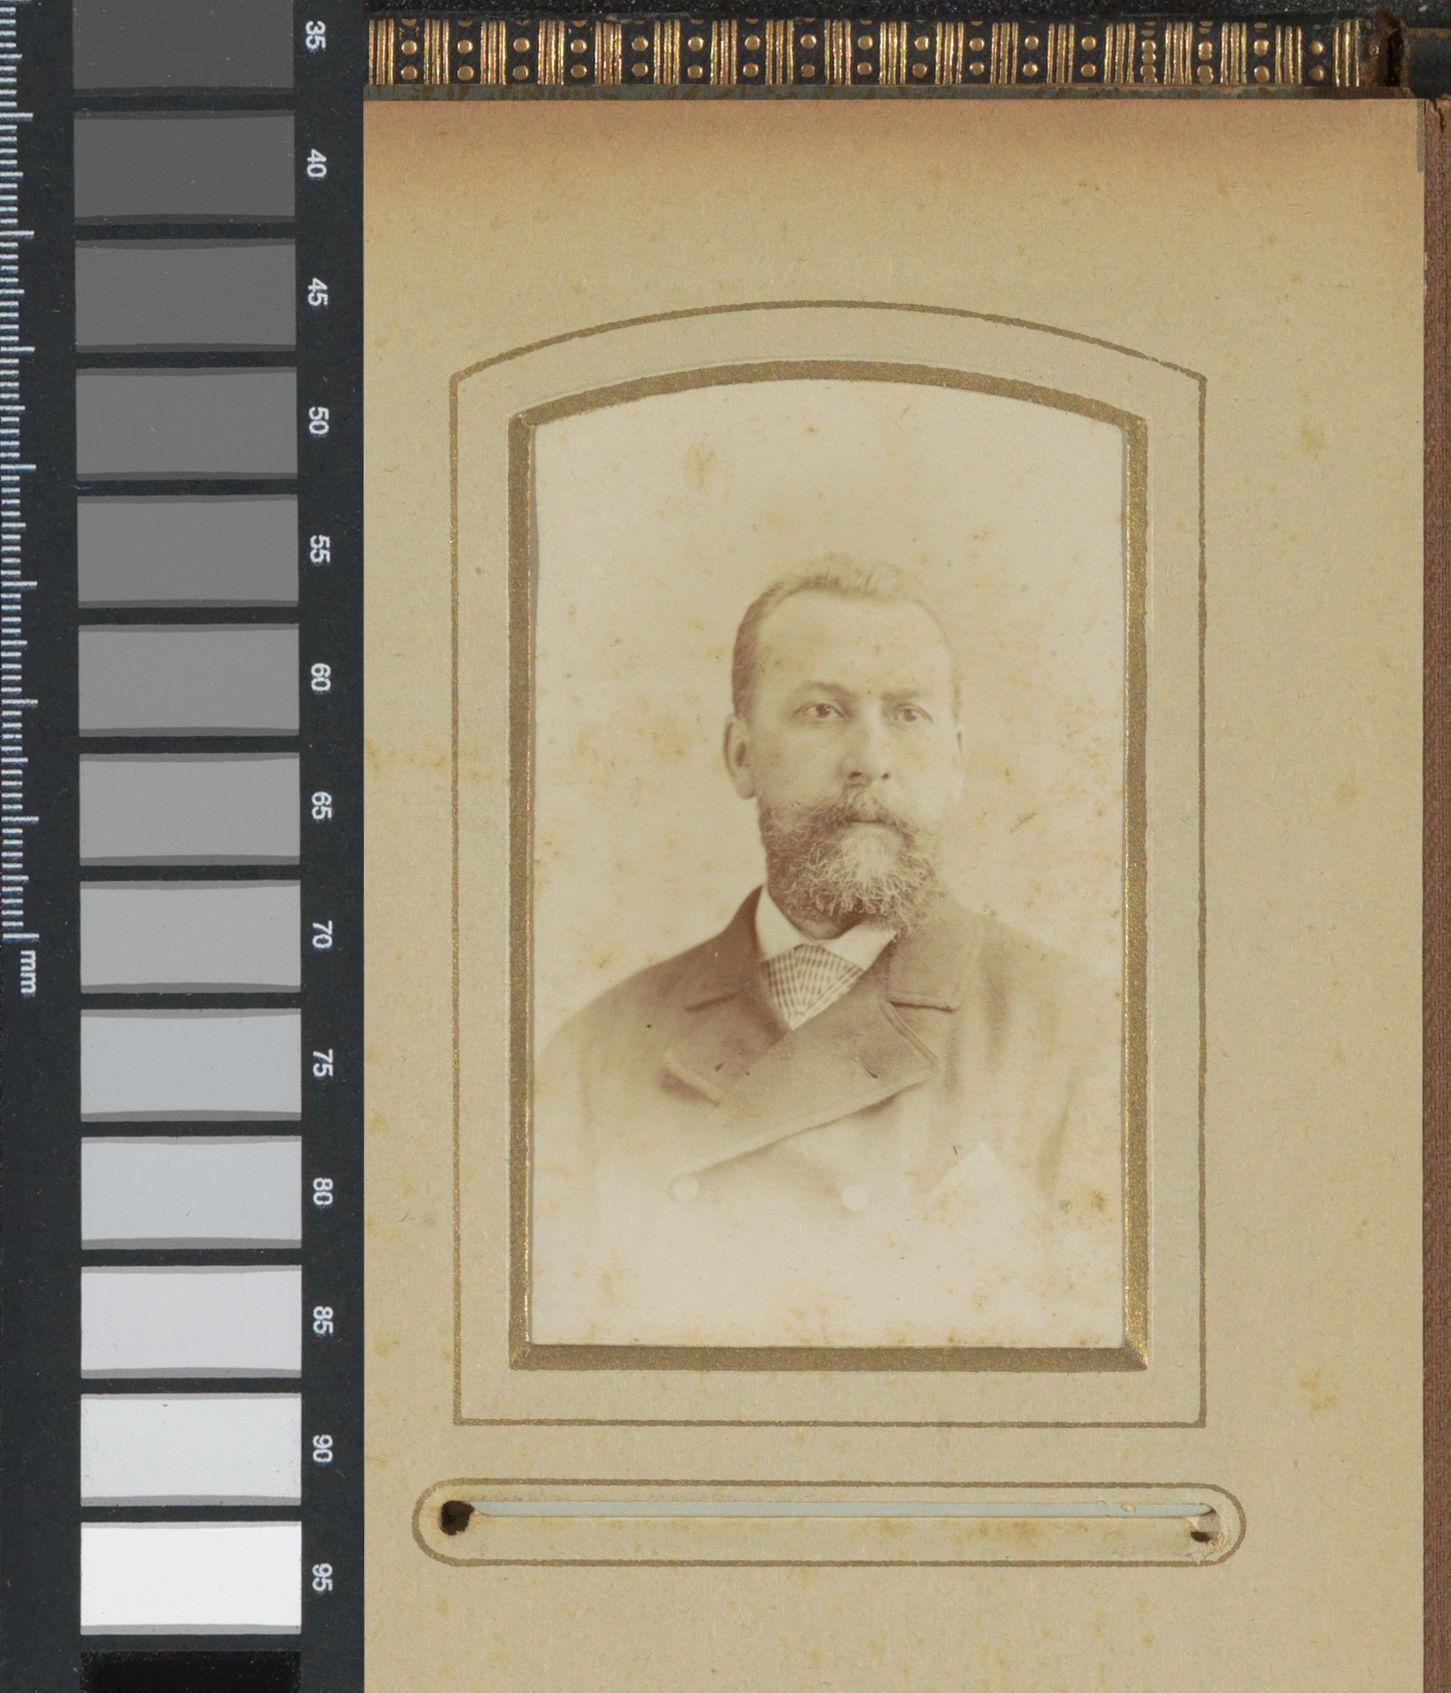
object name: carte de visite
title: Portret van een man met een baard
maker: j. ganz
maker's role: fotograaf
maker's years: 1872-1954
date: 1880-1900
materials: cardboard, paper, photographic support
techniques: albumen print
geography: brussels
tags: adult man, historical persons, beard, brussels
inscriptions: name: ‘J. Ganz [...]’, address: ‘38, Rue de l'Ecuyer, en face des Galeries St. Hubert Bruxelles. Même maison à Zürich.’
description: Onderdeel van Fotoalbum van de familie Boelen.